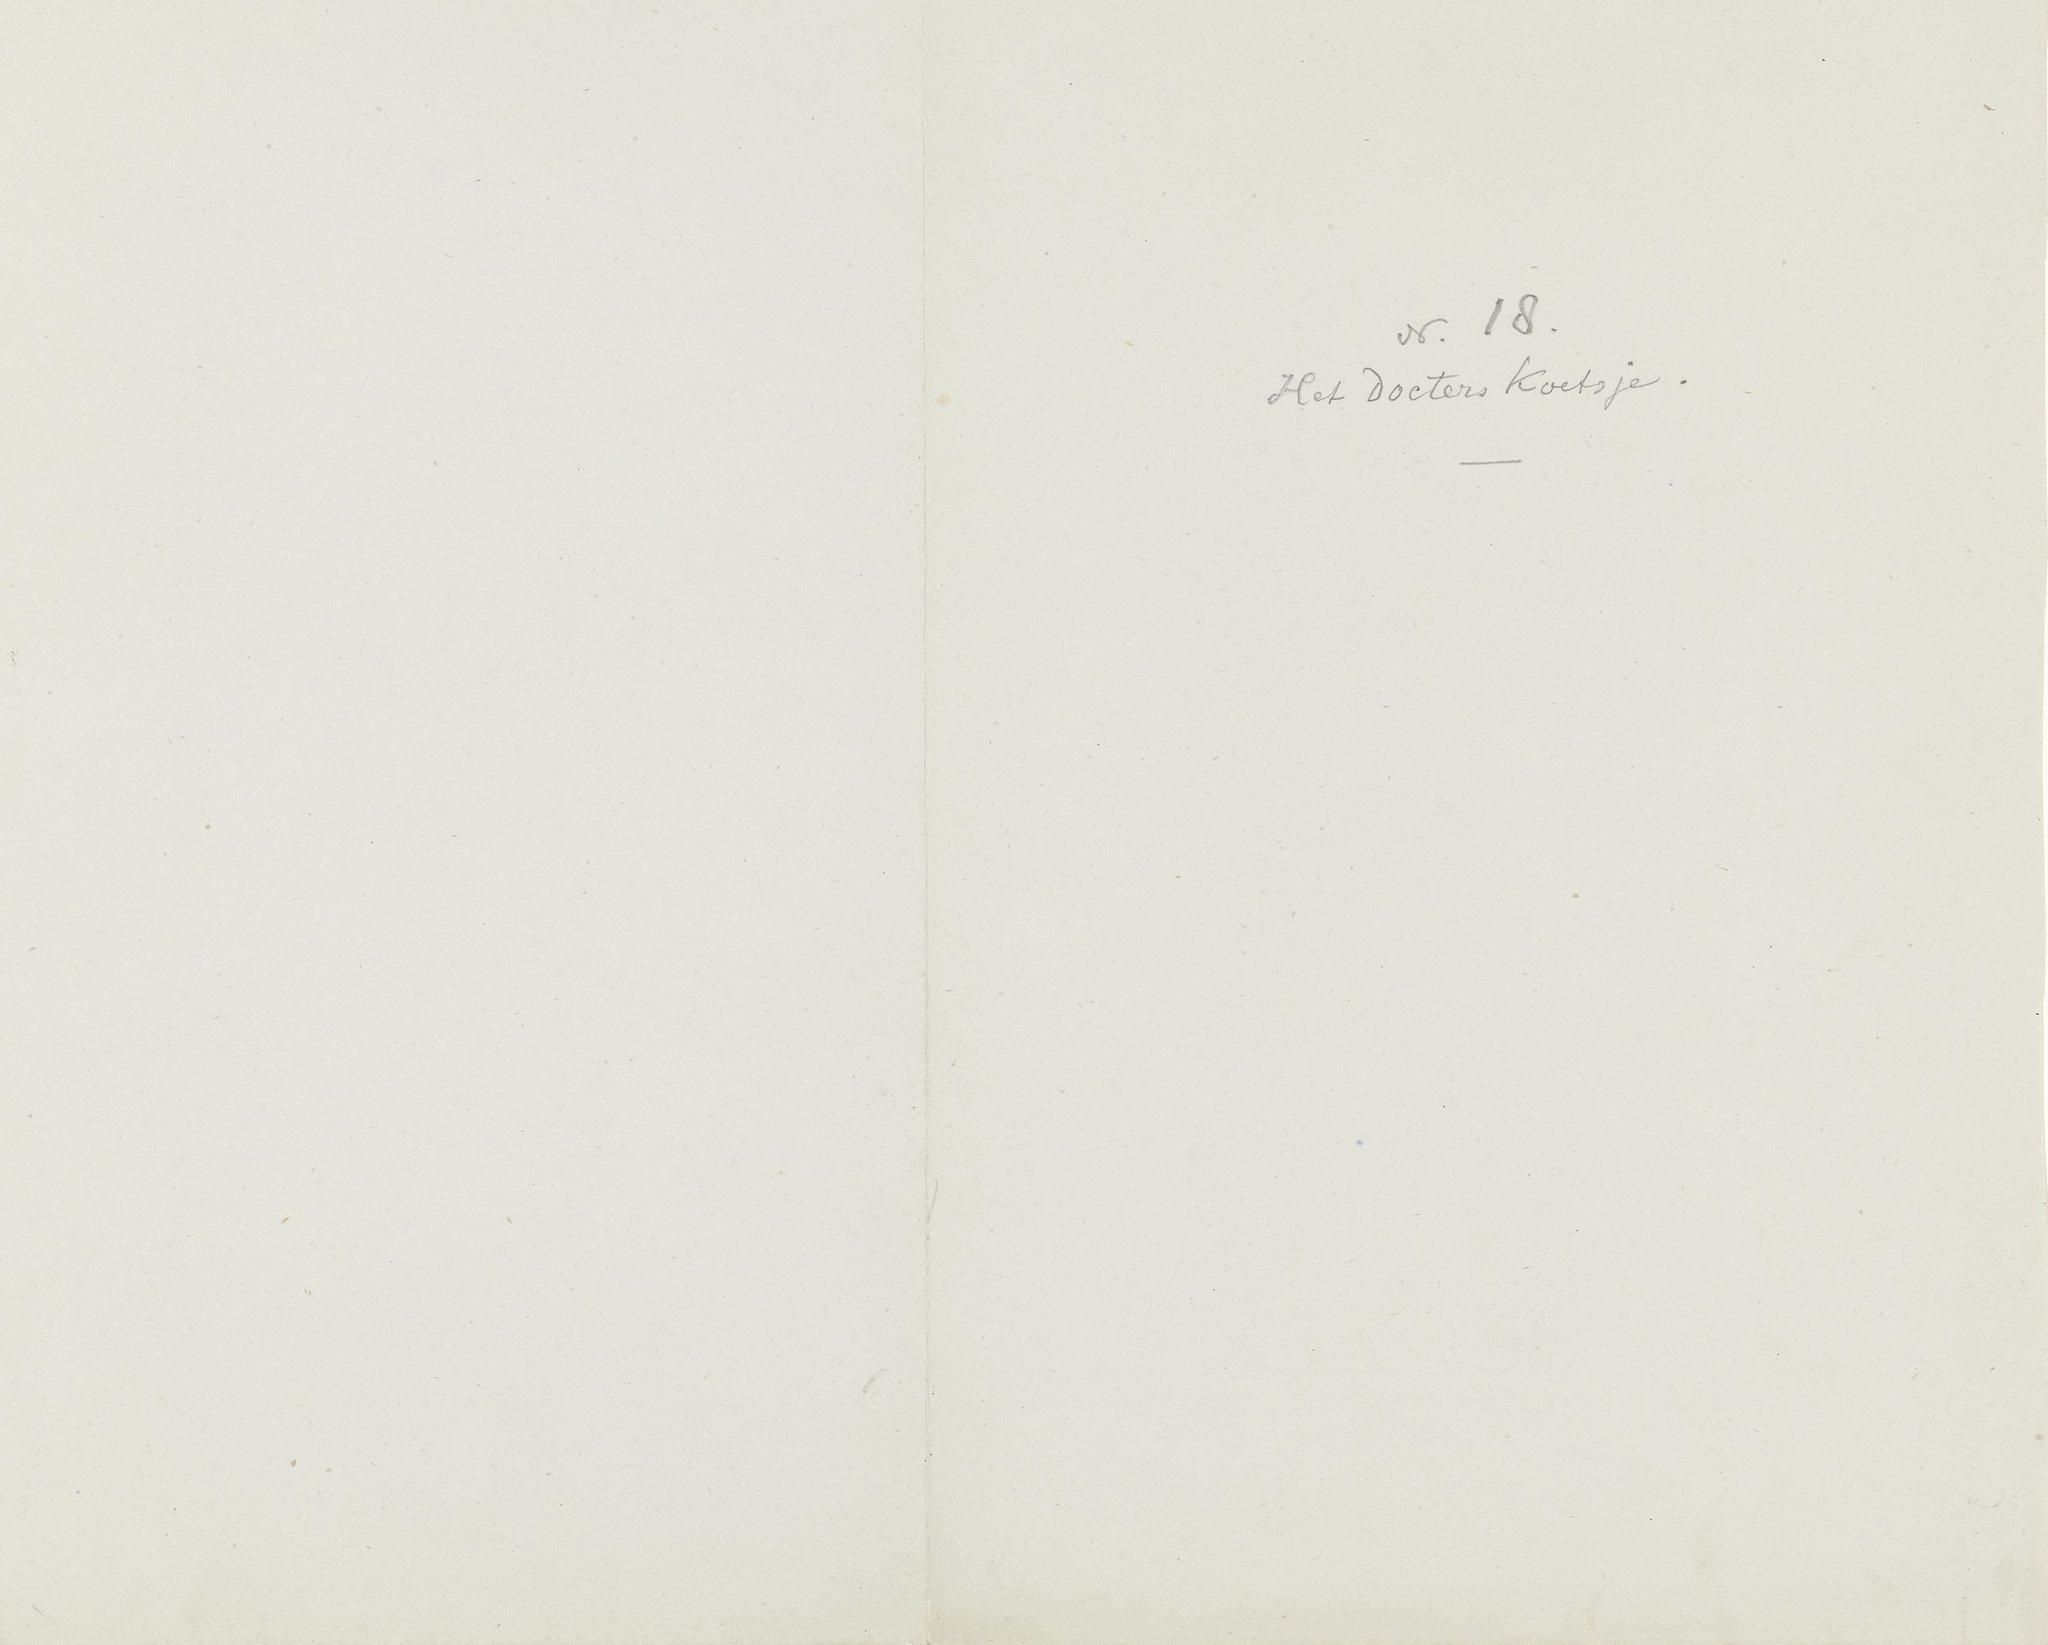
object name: wrapper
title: Omslag voor de verschillende staten van de prent 'Koets' door Cornelis van der Grient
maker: cornelis van der griendt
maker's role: draughtsman, painter, print maker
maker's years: 1827-1918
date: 1894-1918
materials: paper, pencil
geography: netherlands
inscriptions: inscription: ‘6 [...]’